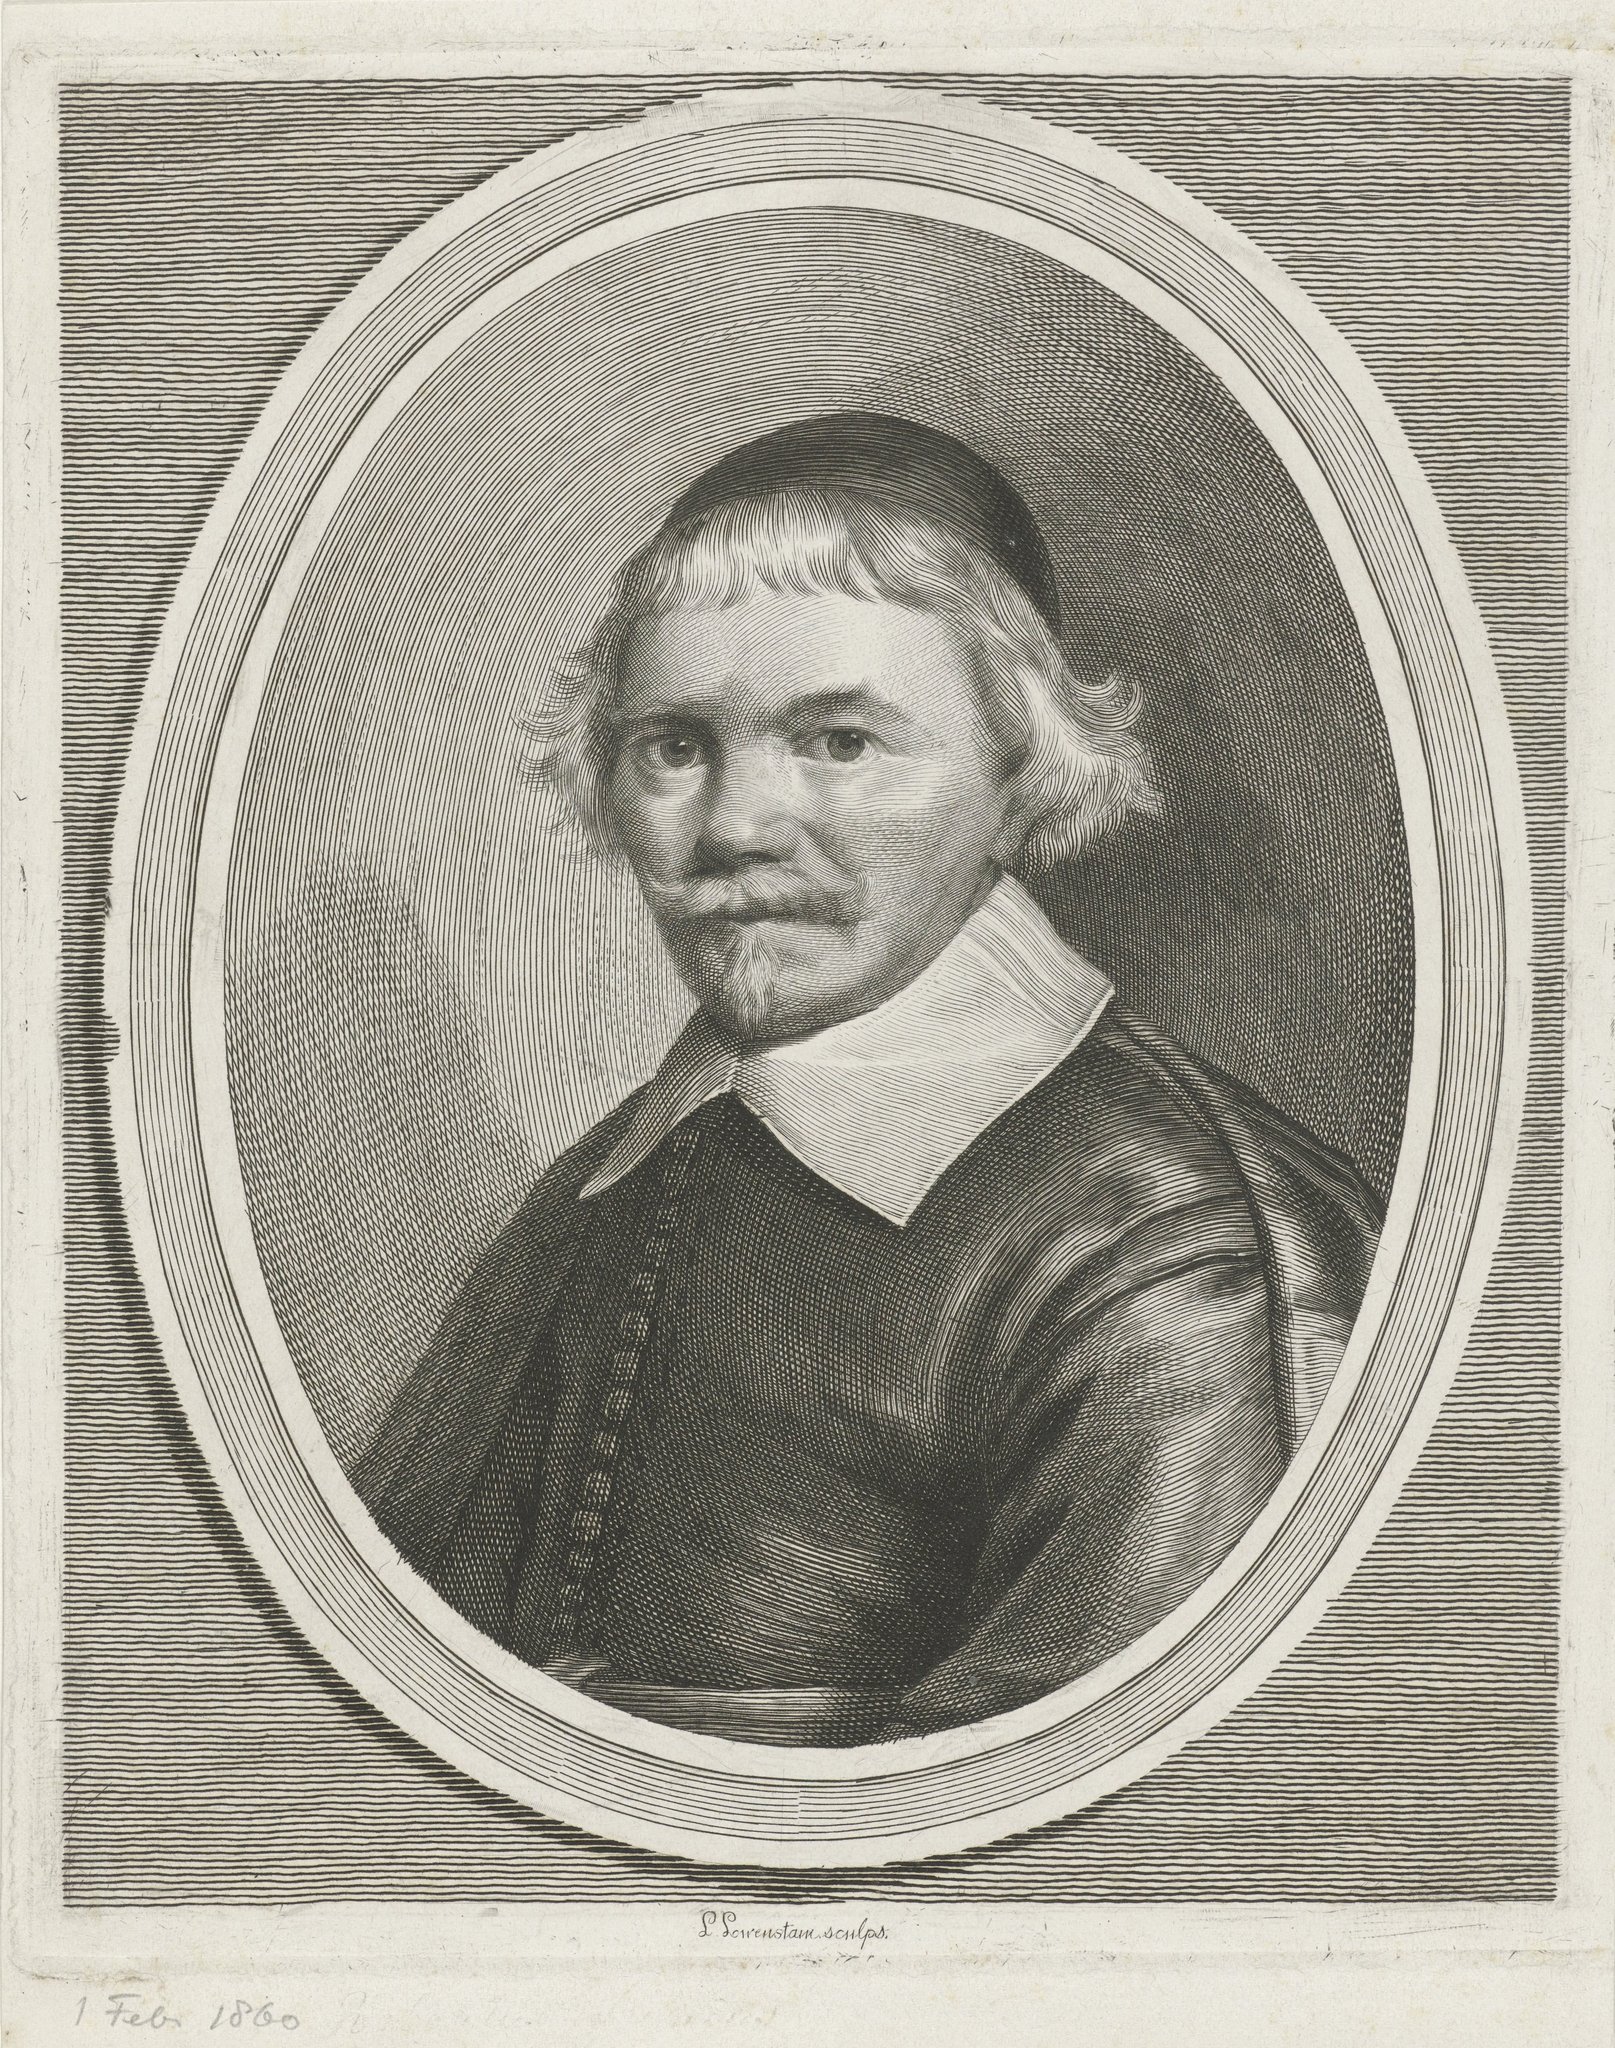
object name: print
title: Portret van Robert Junius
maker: leopold löwenstam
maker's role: print maker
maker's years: 1842-1898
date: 1860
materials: paper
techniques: engraving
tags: rotterdam, amsterdam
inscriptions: collector's mark: Lugt 2228, inscription: ‘1 Feb 1860’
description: Portret van Robert Junius, predikant te Indië, Formosa, Delft en Amsterdam.